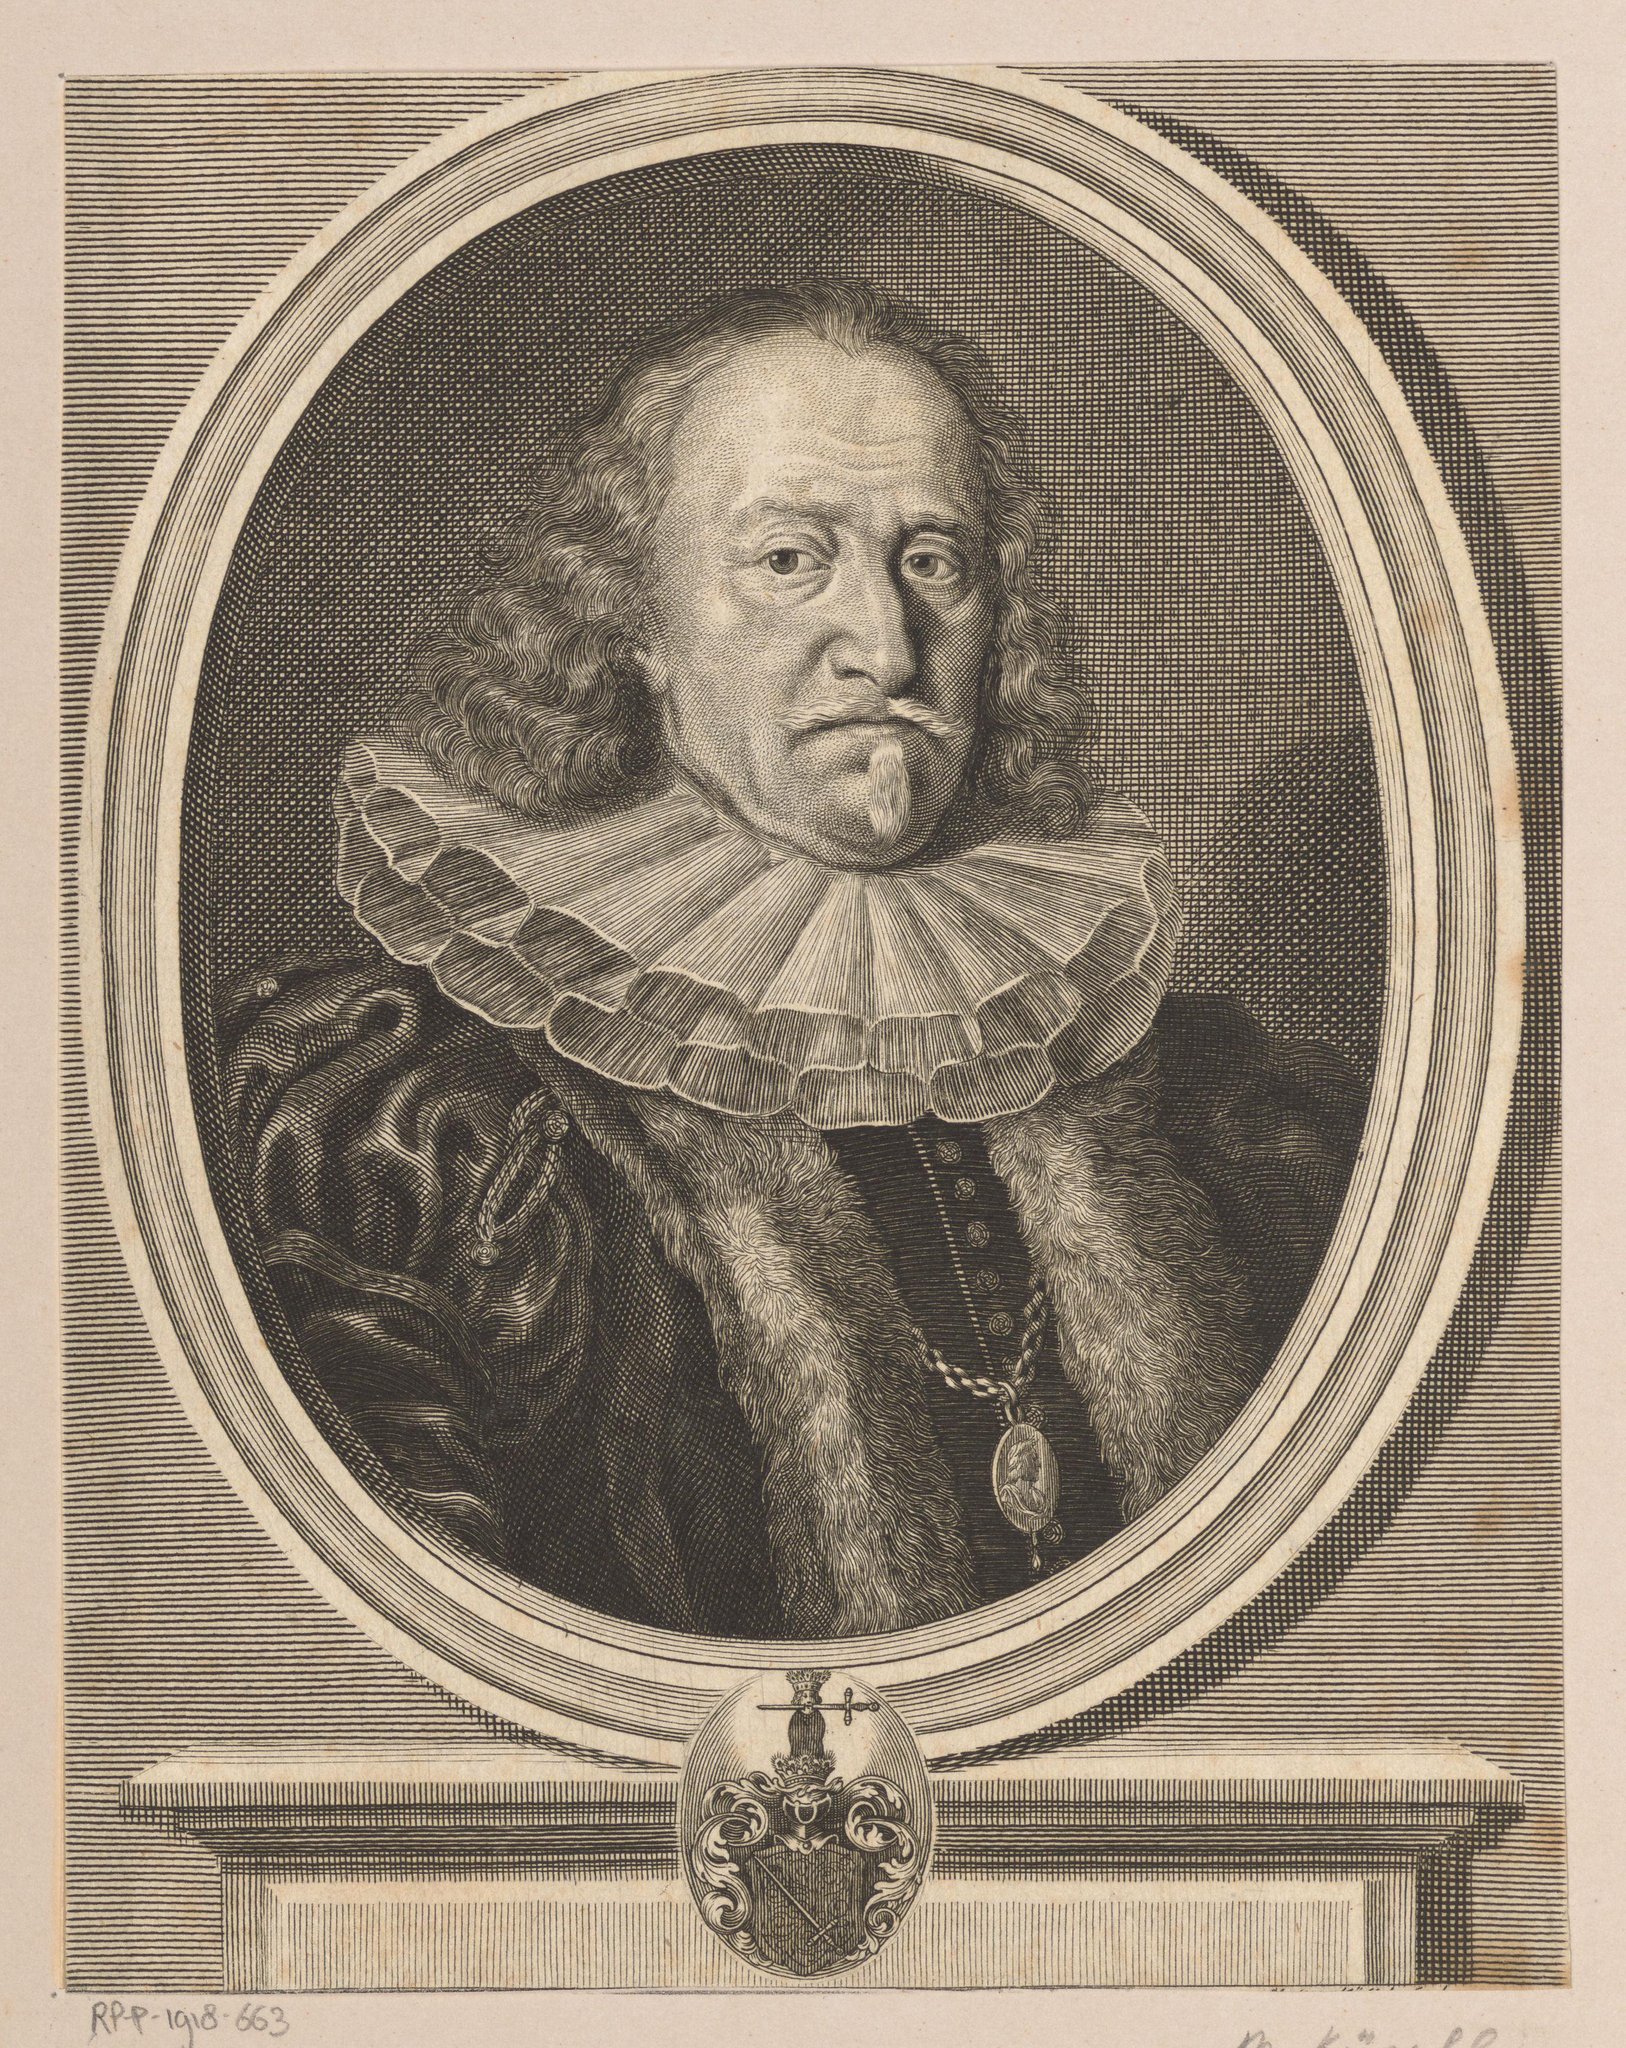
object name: print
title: Portret van Jobst Christoph Kress von Kressenstein I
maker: mathäus küsel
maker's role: print maker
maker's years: 1629-1681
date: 1639-1681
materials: paper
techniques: engraving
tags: historical persons, armorial bearing, heraldry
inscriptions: collector's mark: Lugt 2233